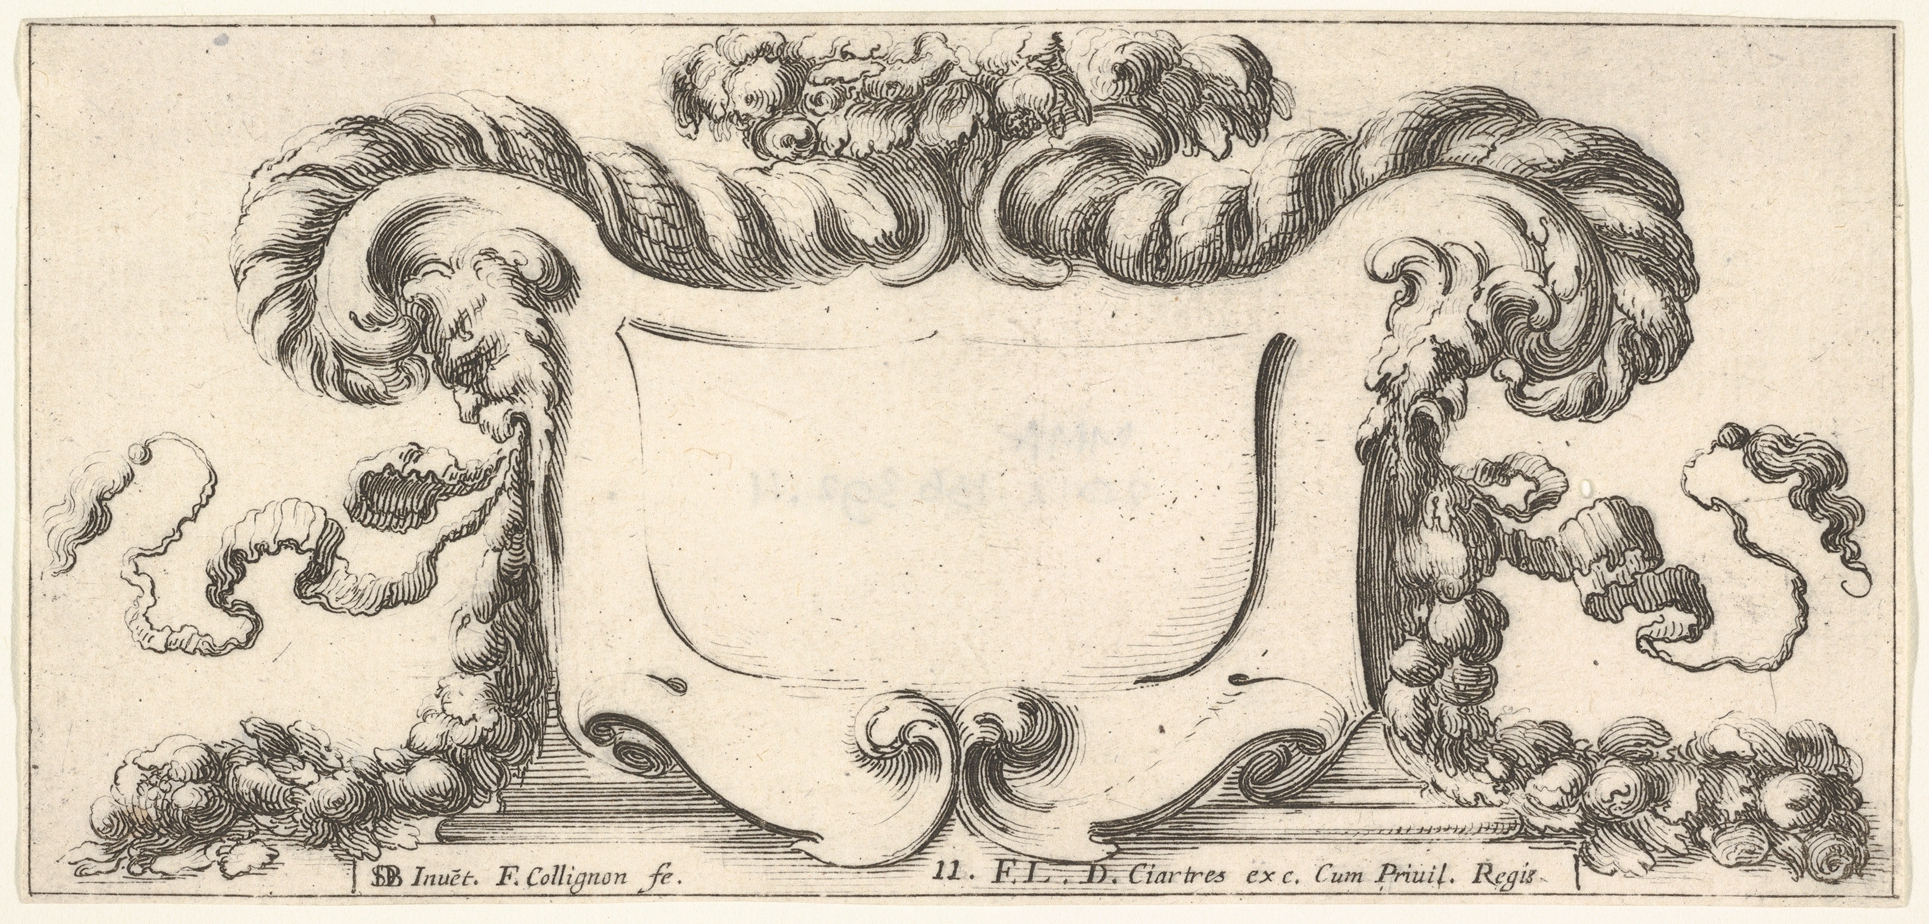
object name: print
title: Plate 11: a cartouche with fruits, flowers, and leaves at top, a mask of a faun in profile to either side with a festoon of fruits and flowers in each of their mouths, from "Twelve cartouches" (Recueil de douze cartouches)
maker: françois collignon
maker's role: artist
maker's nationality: french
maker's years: 1605-1687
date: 1640-1645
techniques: etching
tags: masks,cartouches,fruit,flowers